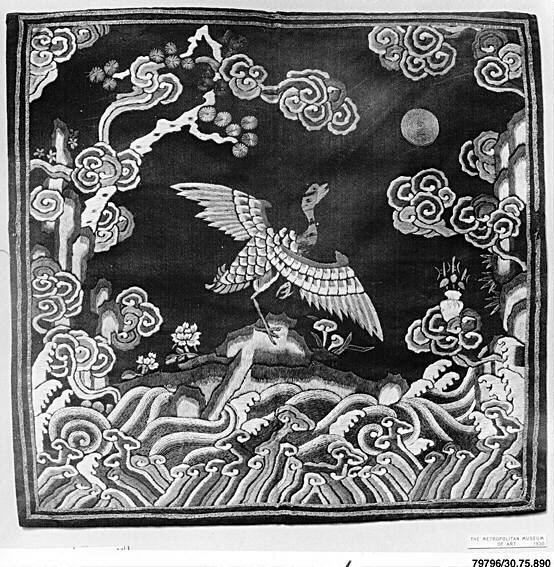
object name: rank badge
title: Rank Badge with Wild Goose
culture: chinese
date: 1701-1733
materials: metal thread, silk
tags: geese